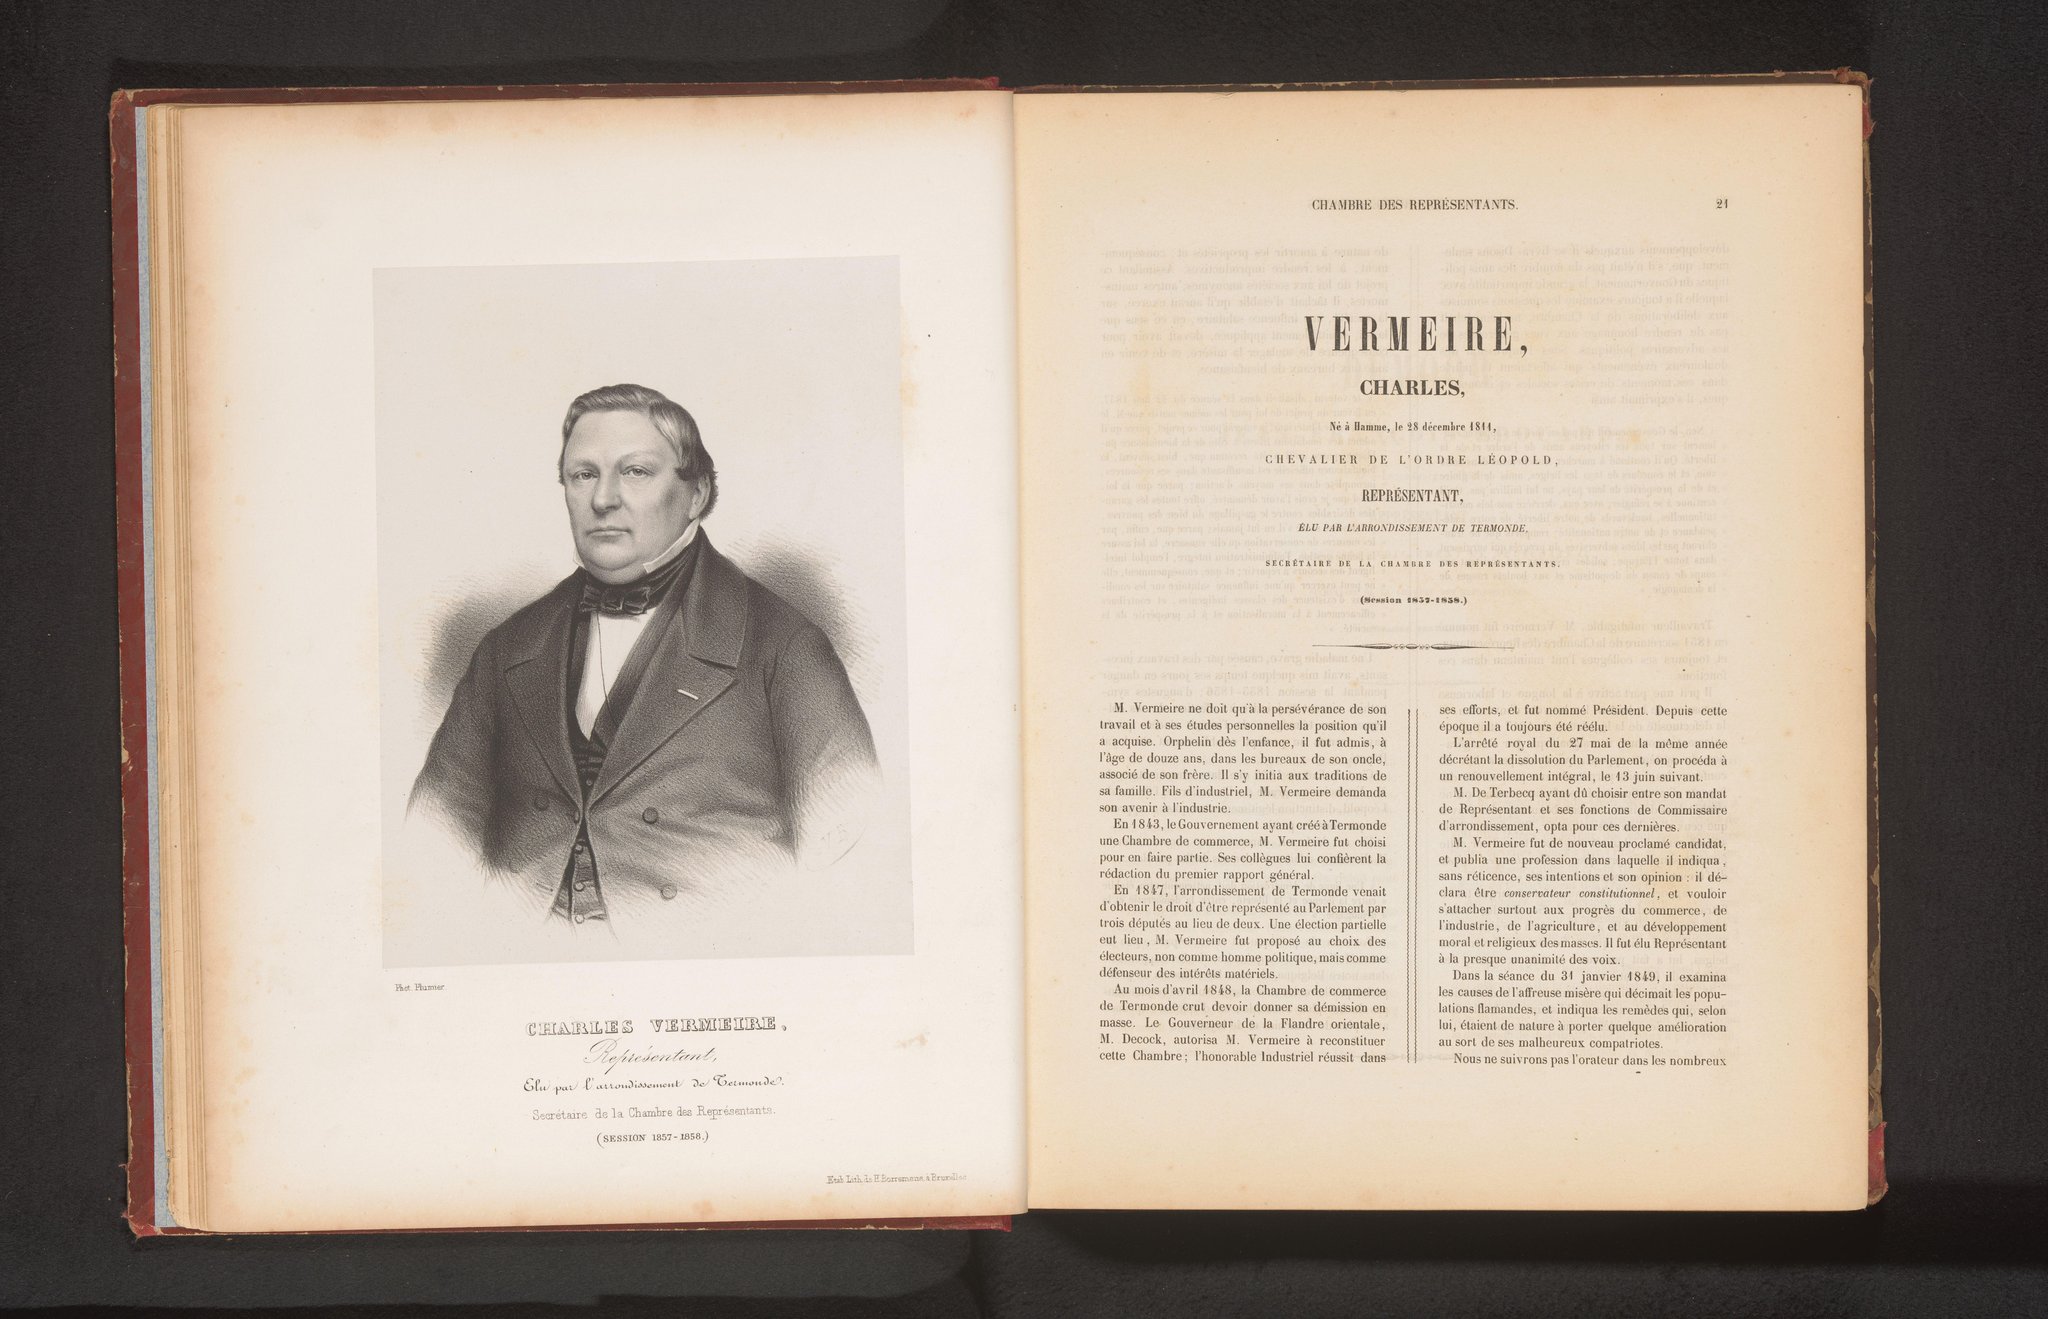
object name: print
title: Reproductie van een foto van een portret van Charles Vermeire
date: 1853-1858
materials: paper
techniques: lithograph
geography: brussels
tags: politician, historical persons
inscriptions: inscription: ‘Représentant,/ Elu par l'arrondissement de Termonde./ Secrétaire de la Chambre des Représentants./ (session 1857-1858.)’